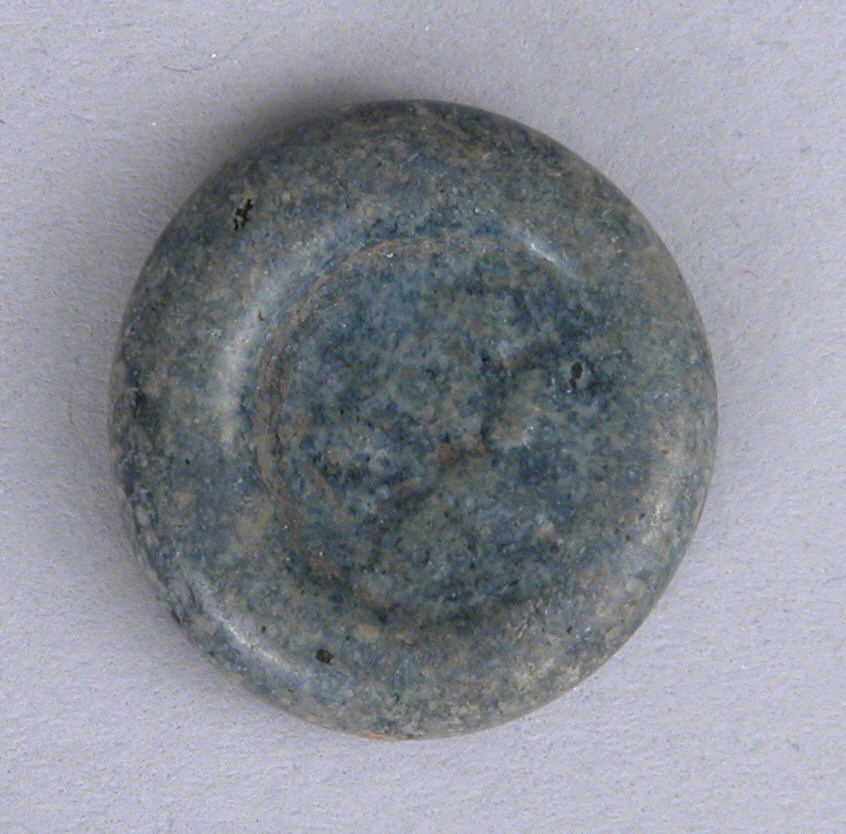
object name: coin weight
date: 901-1200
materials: glass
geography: egypt